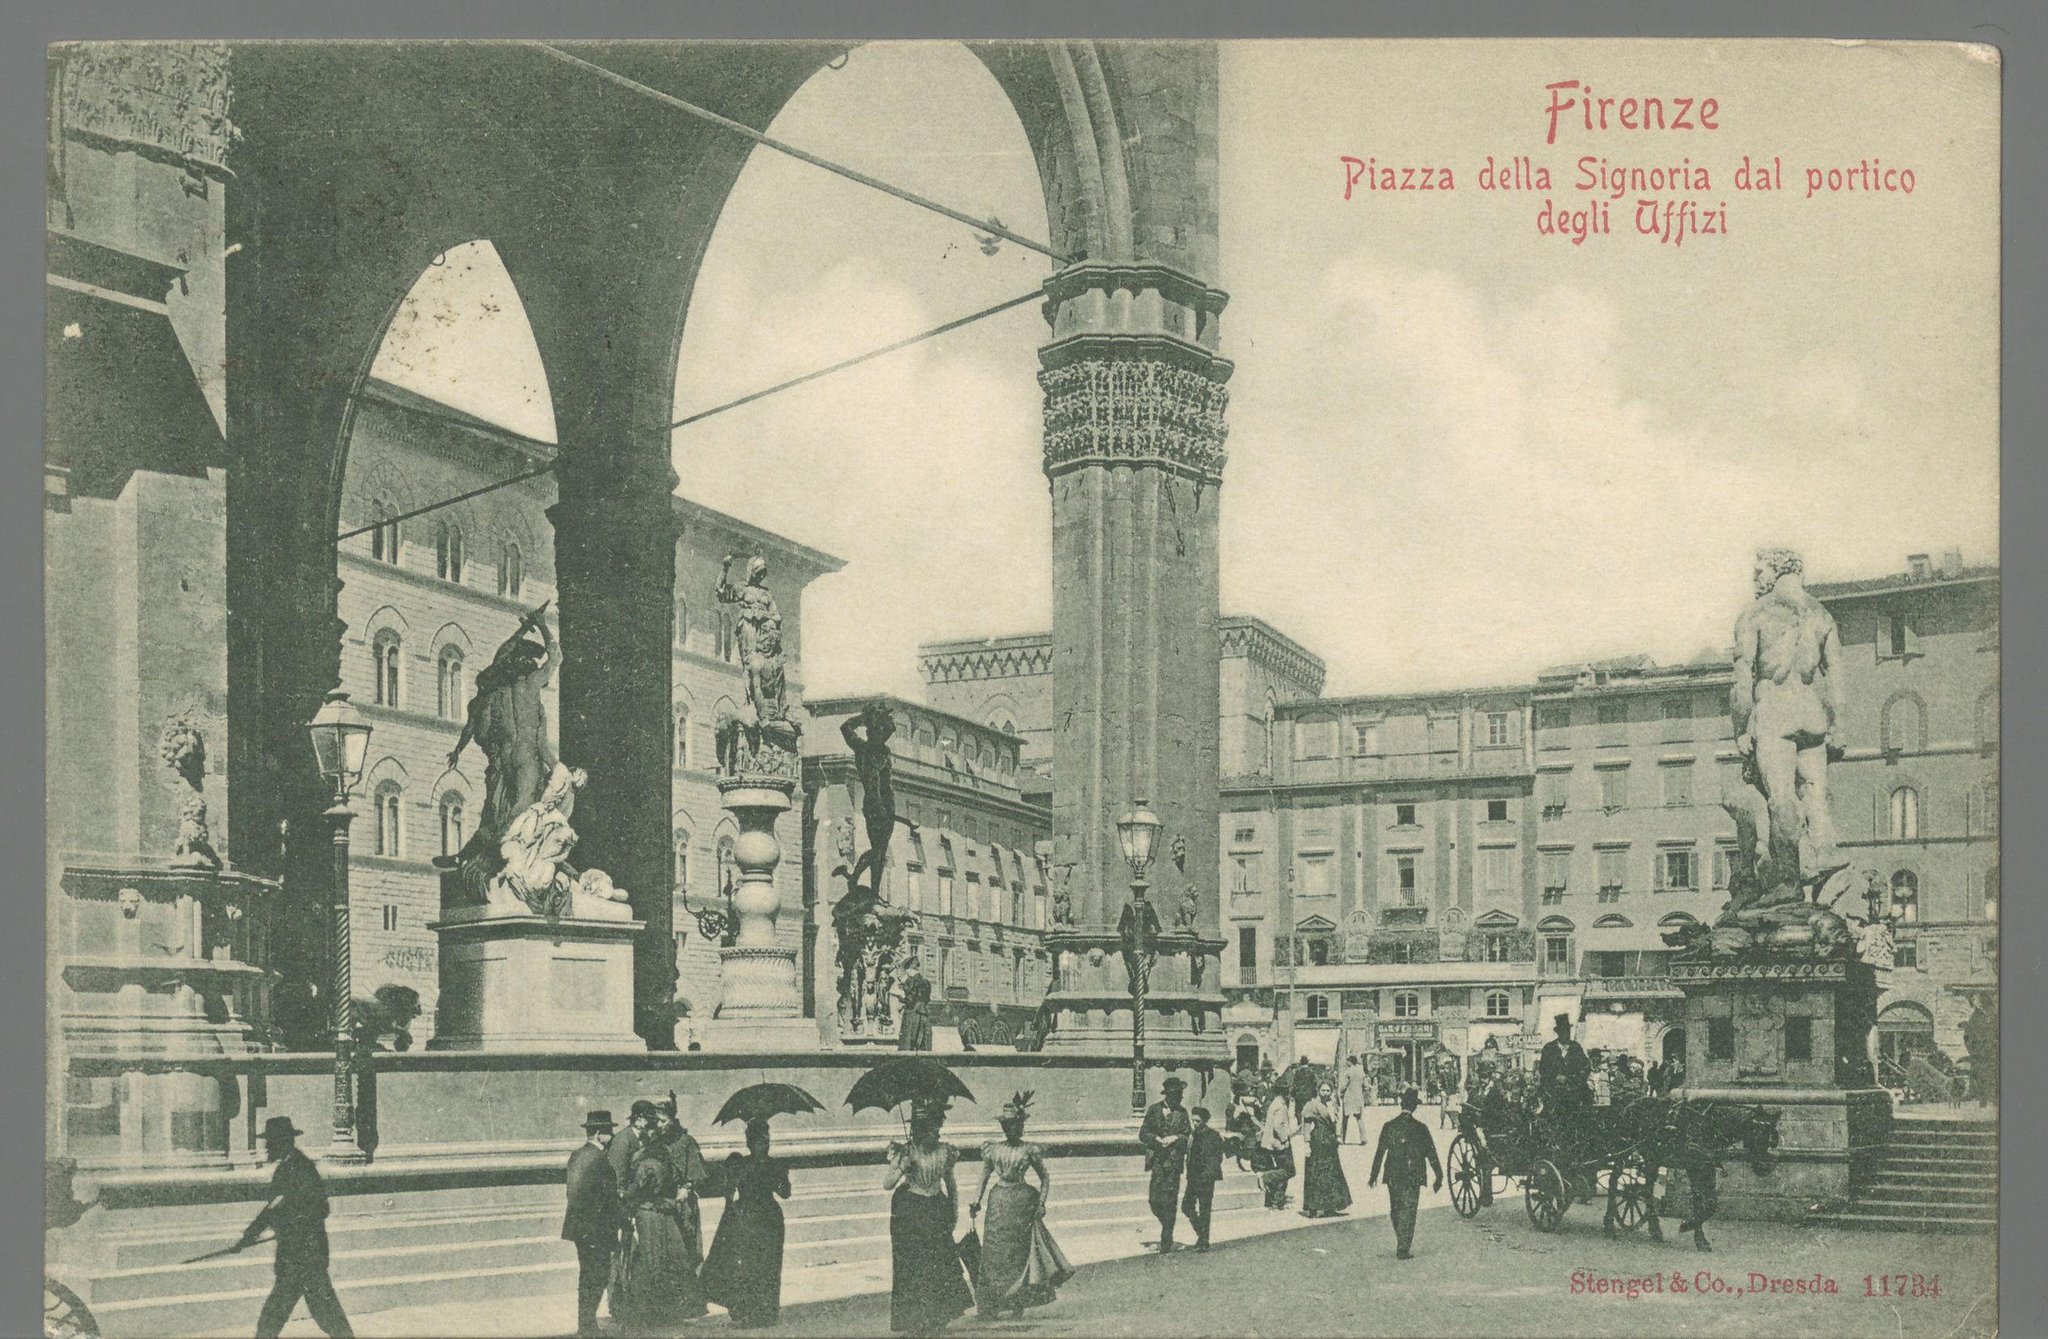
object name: photomechanical print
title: Firenze. Piazza della Signoria dal portico degli Uffizi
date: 1889-1905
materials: cardboard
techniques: photograph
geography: florence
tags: urban housing, monument, statue (+ city(-scape) with figures, staffage), square, place, circus, etc. (+ city(-scape) with figures, staffage)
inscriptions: poststempel, verso, gestempeld